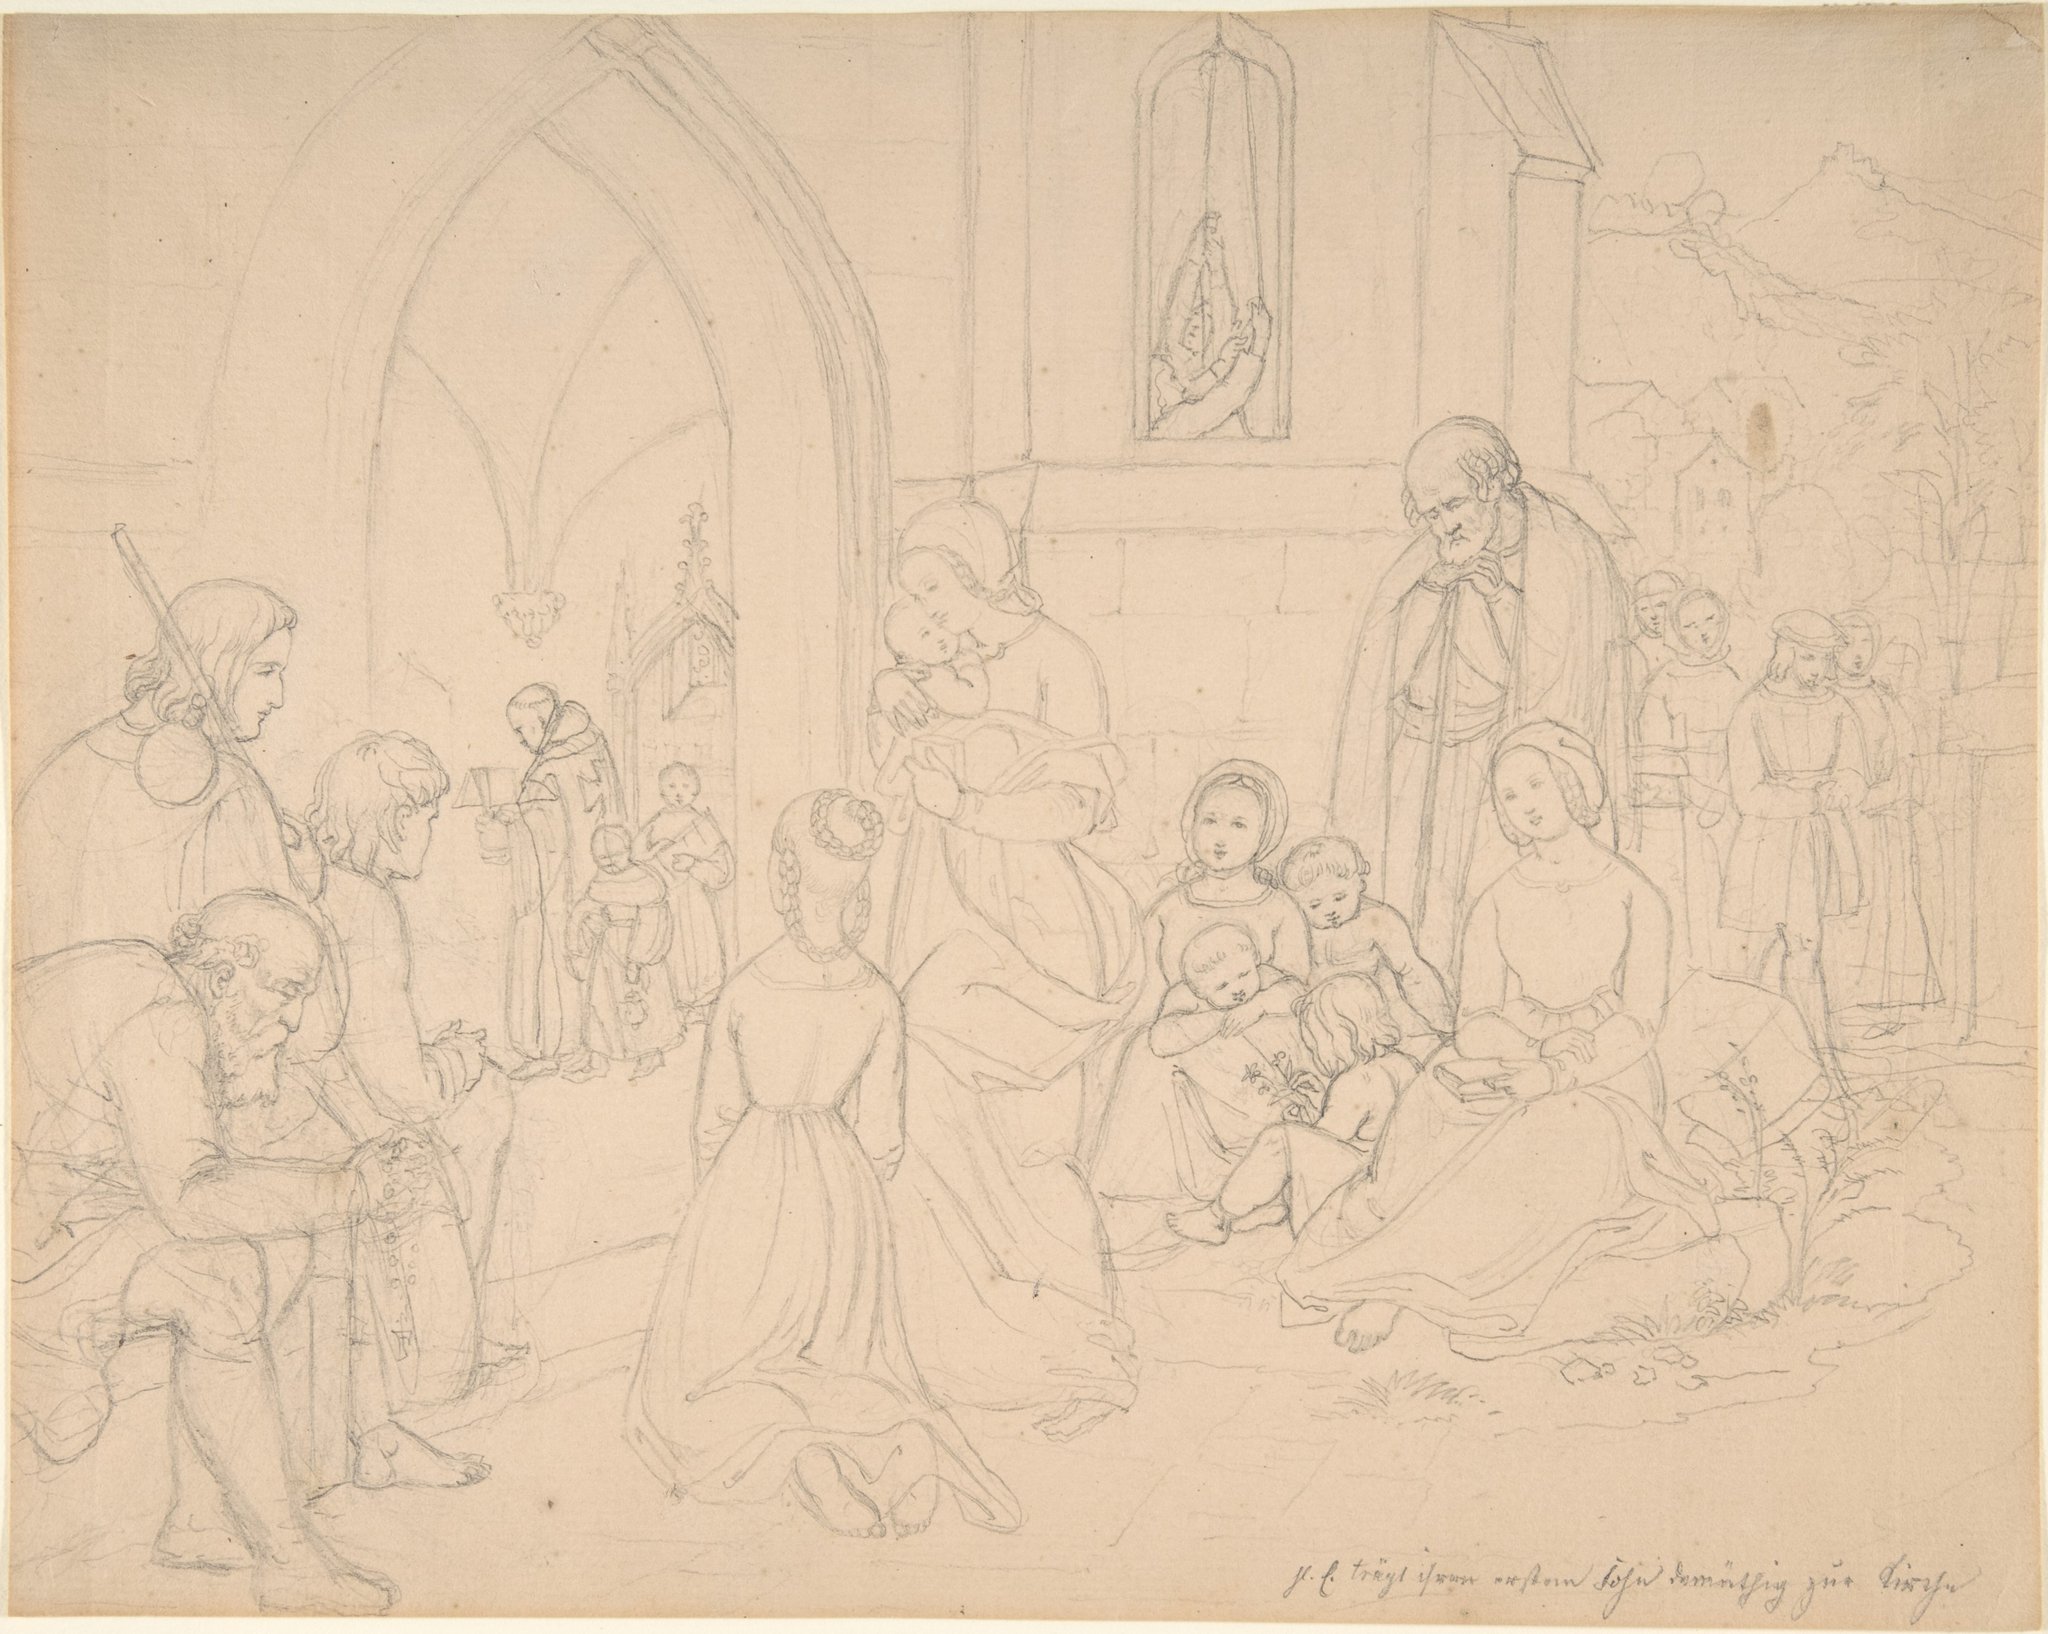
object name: drawing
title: Saint Elizabeth Carrying Her First-born Son to the Church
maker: ludwig emil grimm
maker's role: artist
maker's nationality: german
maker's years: 1790-1863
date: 1850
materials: graphite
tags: churches,infants,women,saints